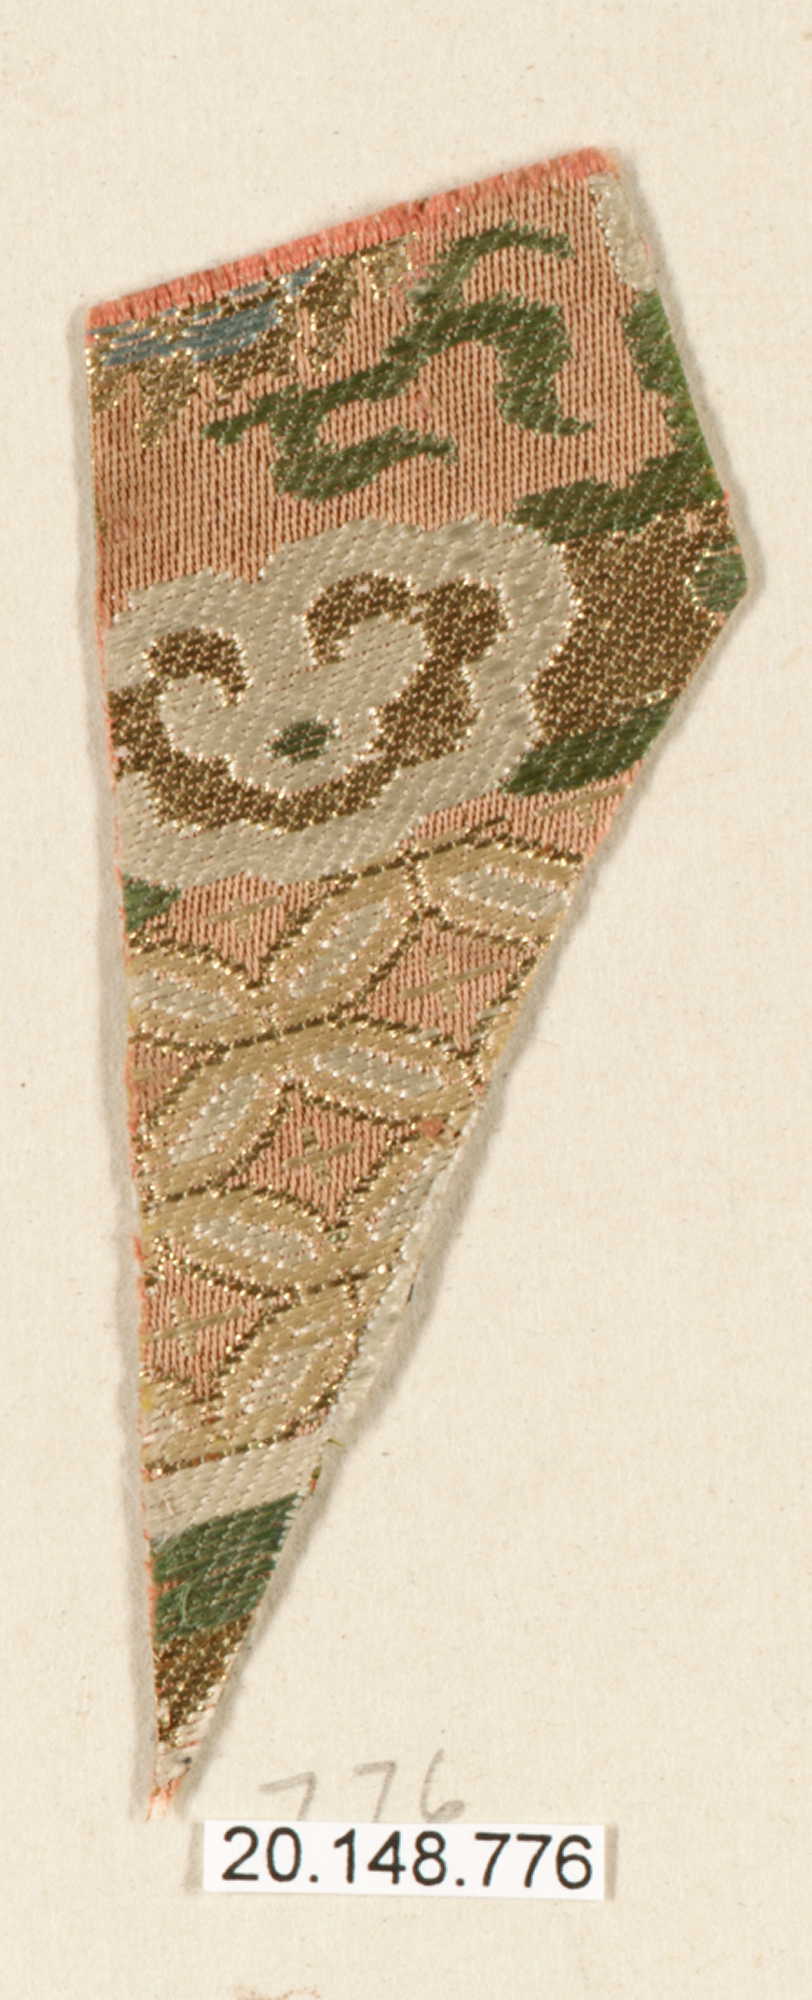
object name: piece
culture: japanese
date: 1601-1700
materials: silk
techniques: compound weave